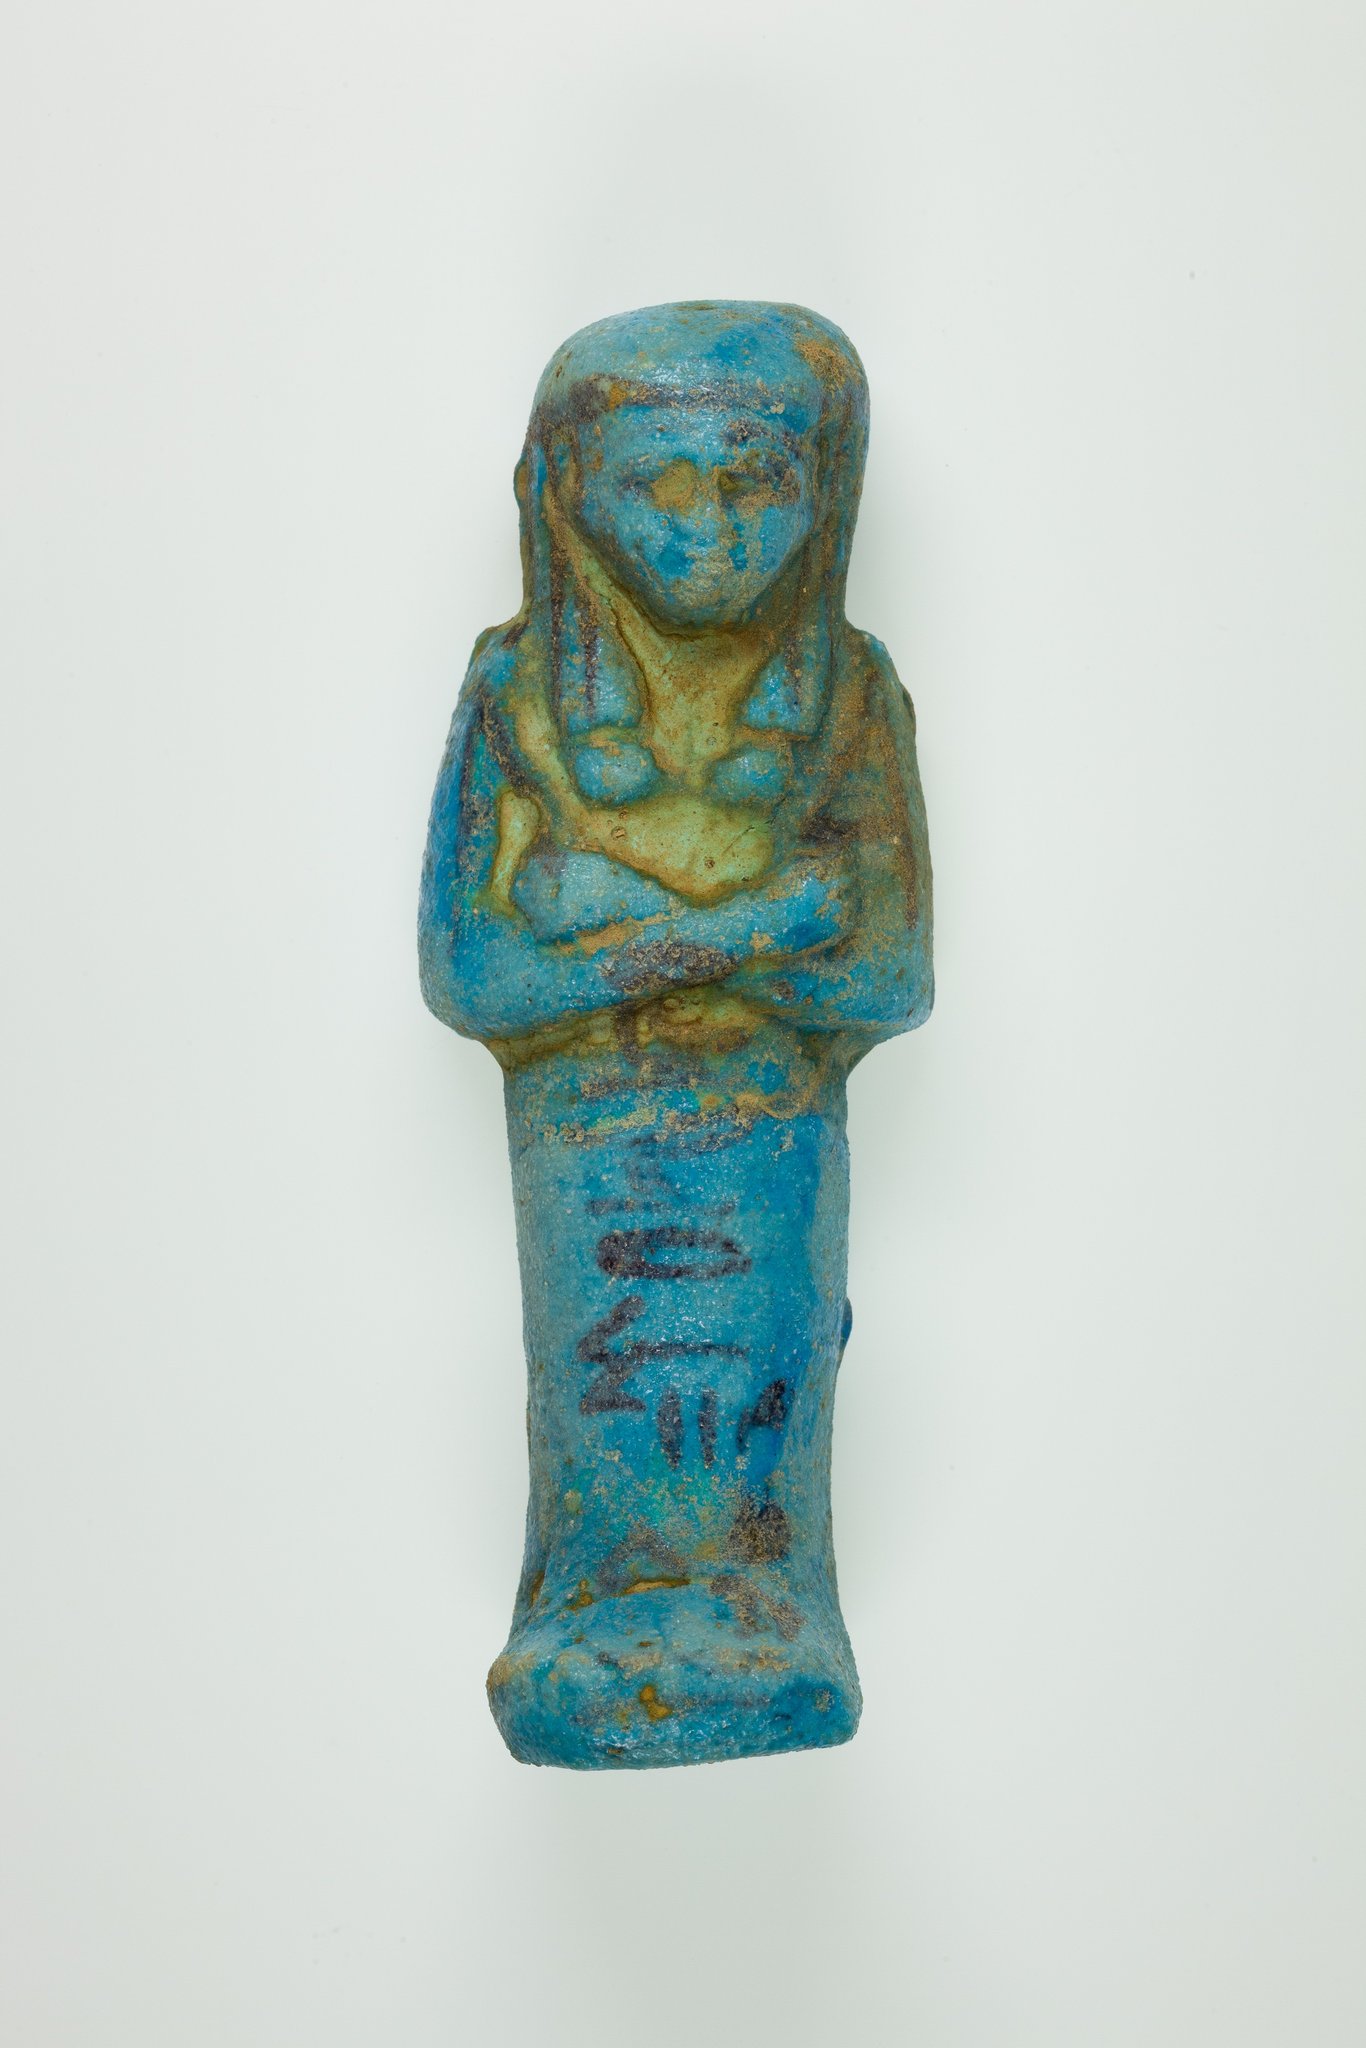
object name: worker shabti, henettawy c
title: Worker Shabti of Henettawy (C), Daughter of Isetemkheb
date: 990-970 BCE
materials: faience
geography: egypt